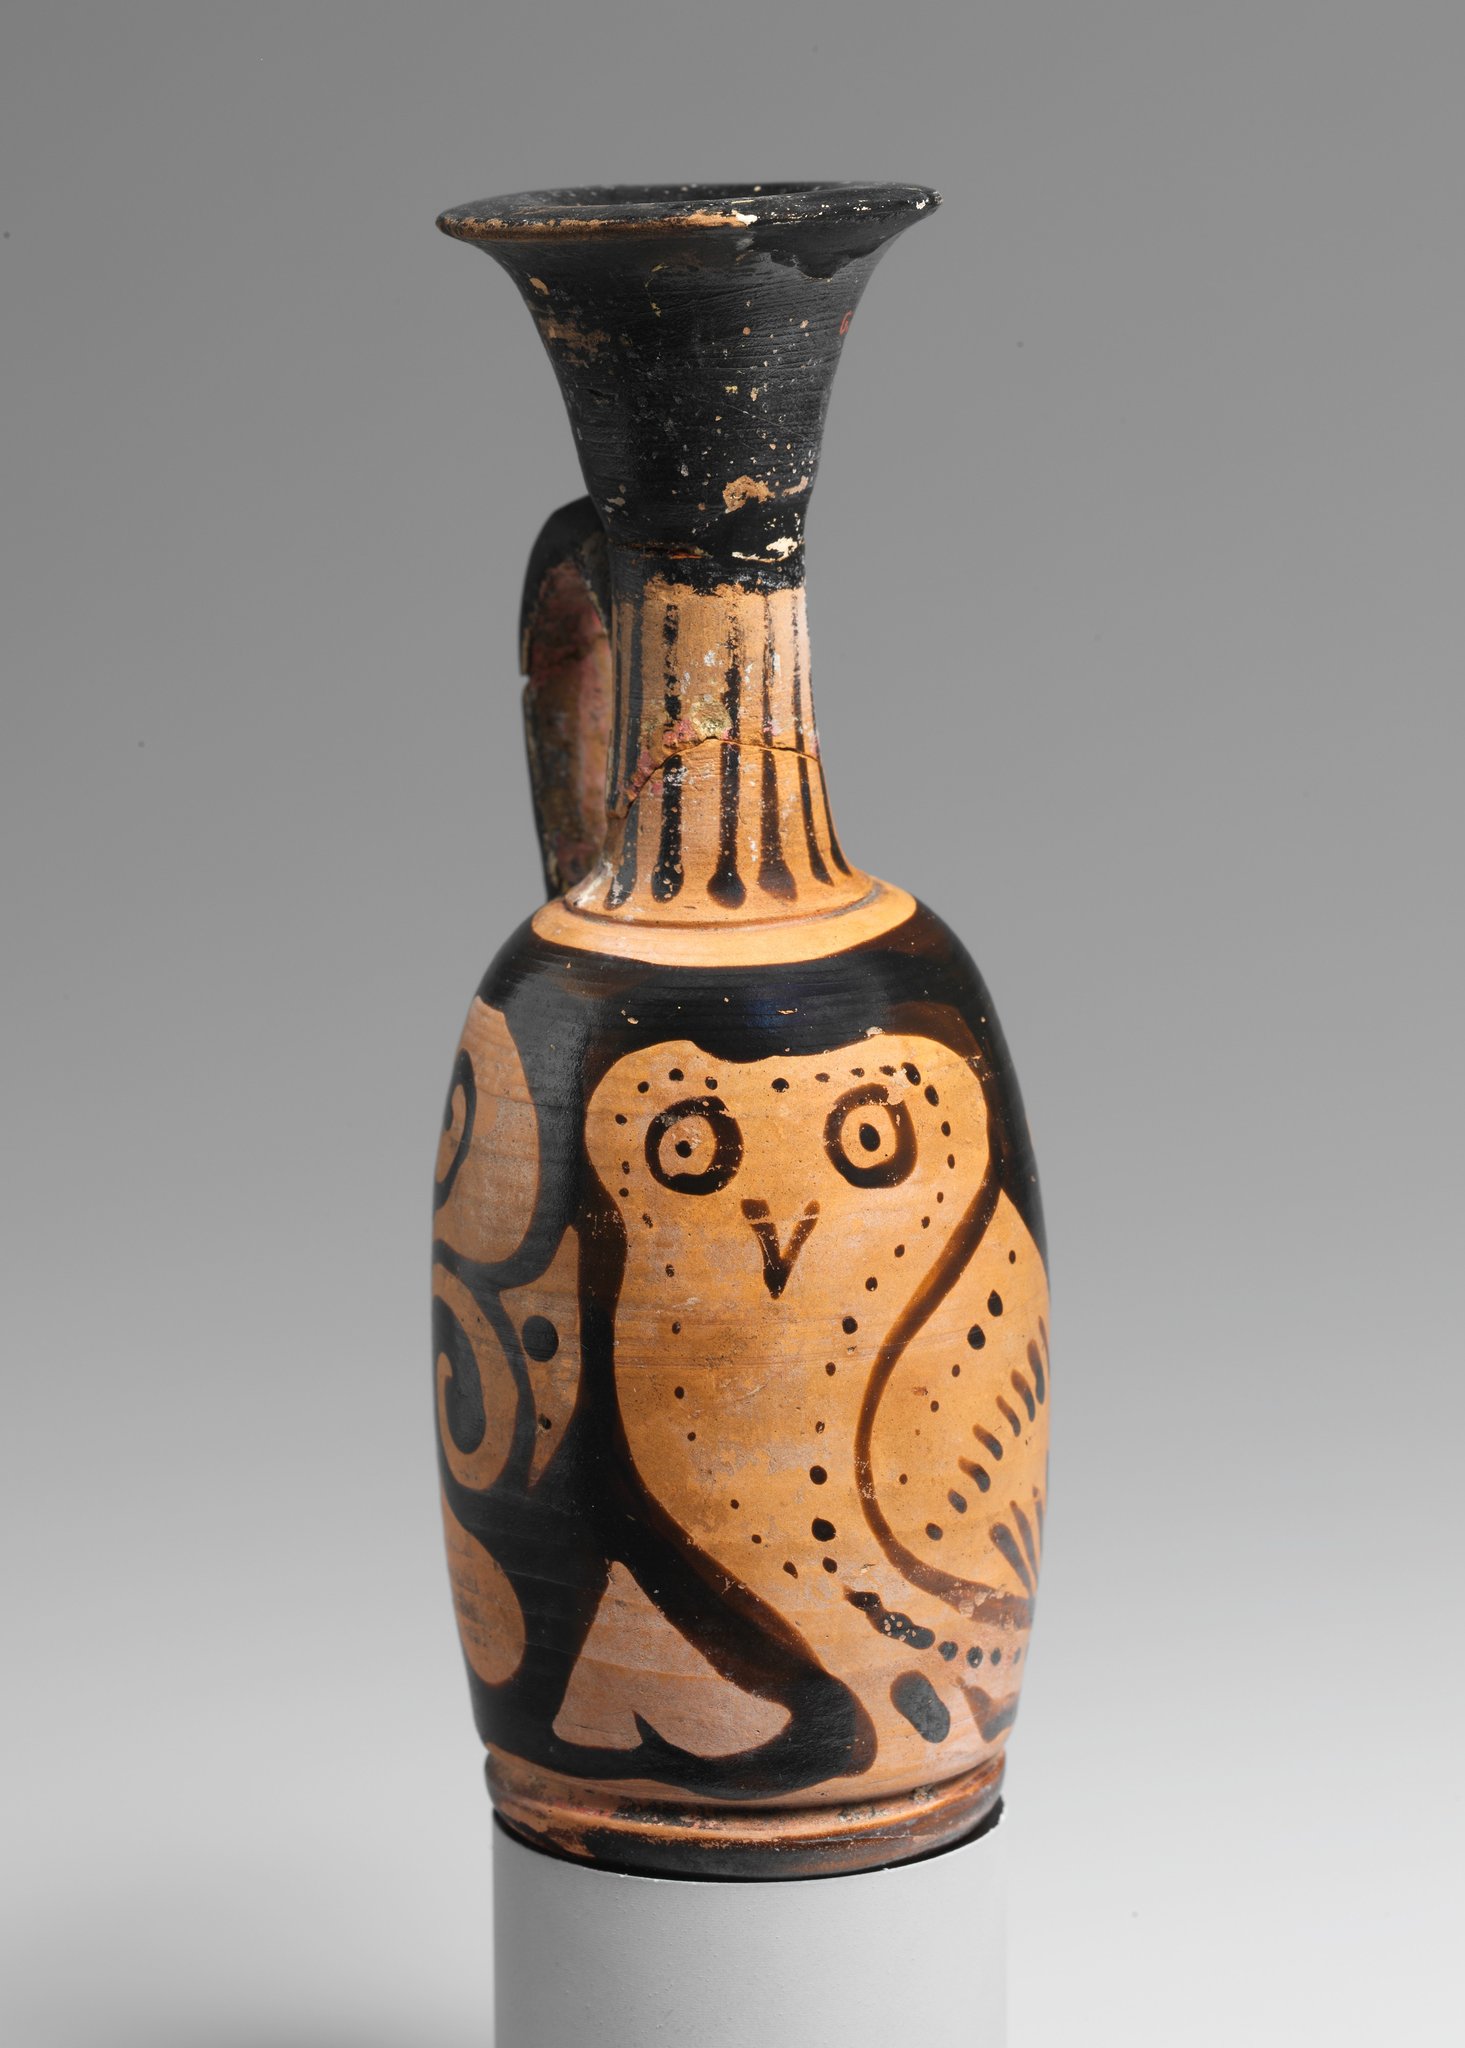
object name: lekythos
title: Terracotta lekythos (oil flask) with an owl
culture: greek, south italian, apulian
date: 400-301 BCE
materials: terracotta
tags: owls